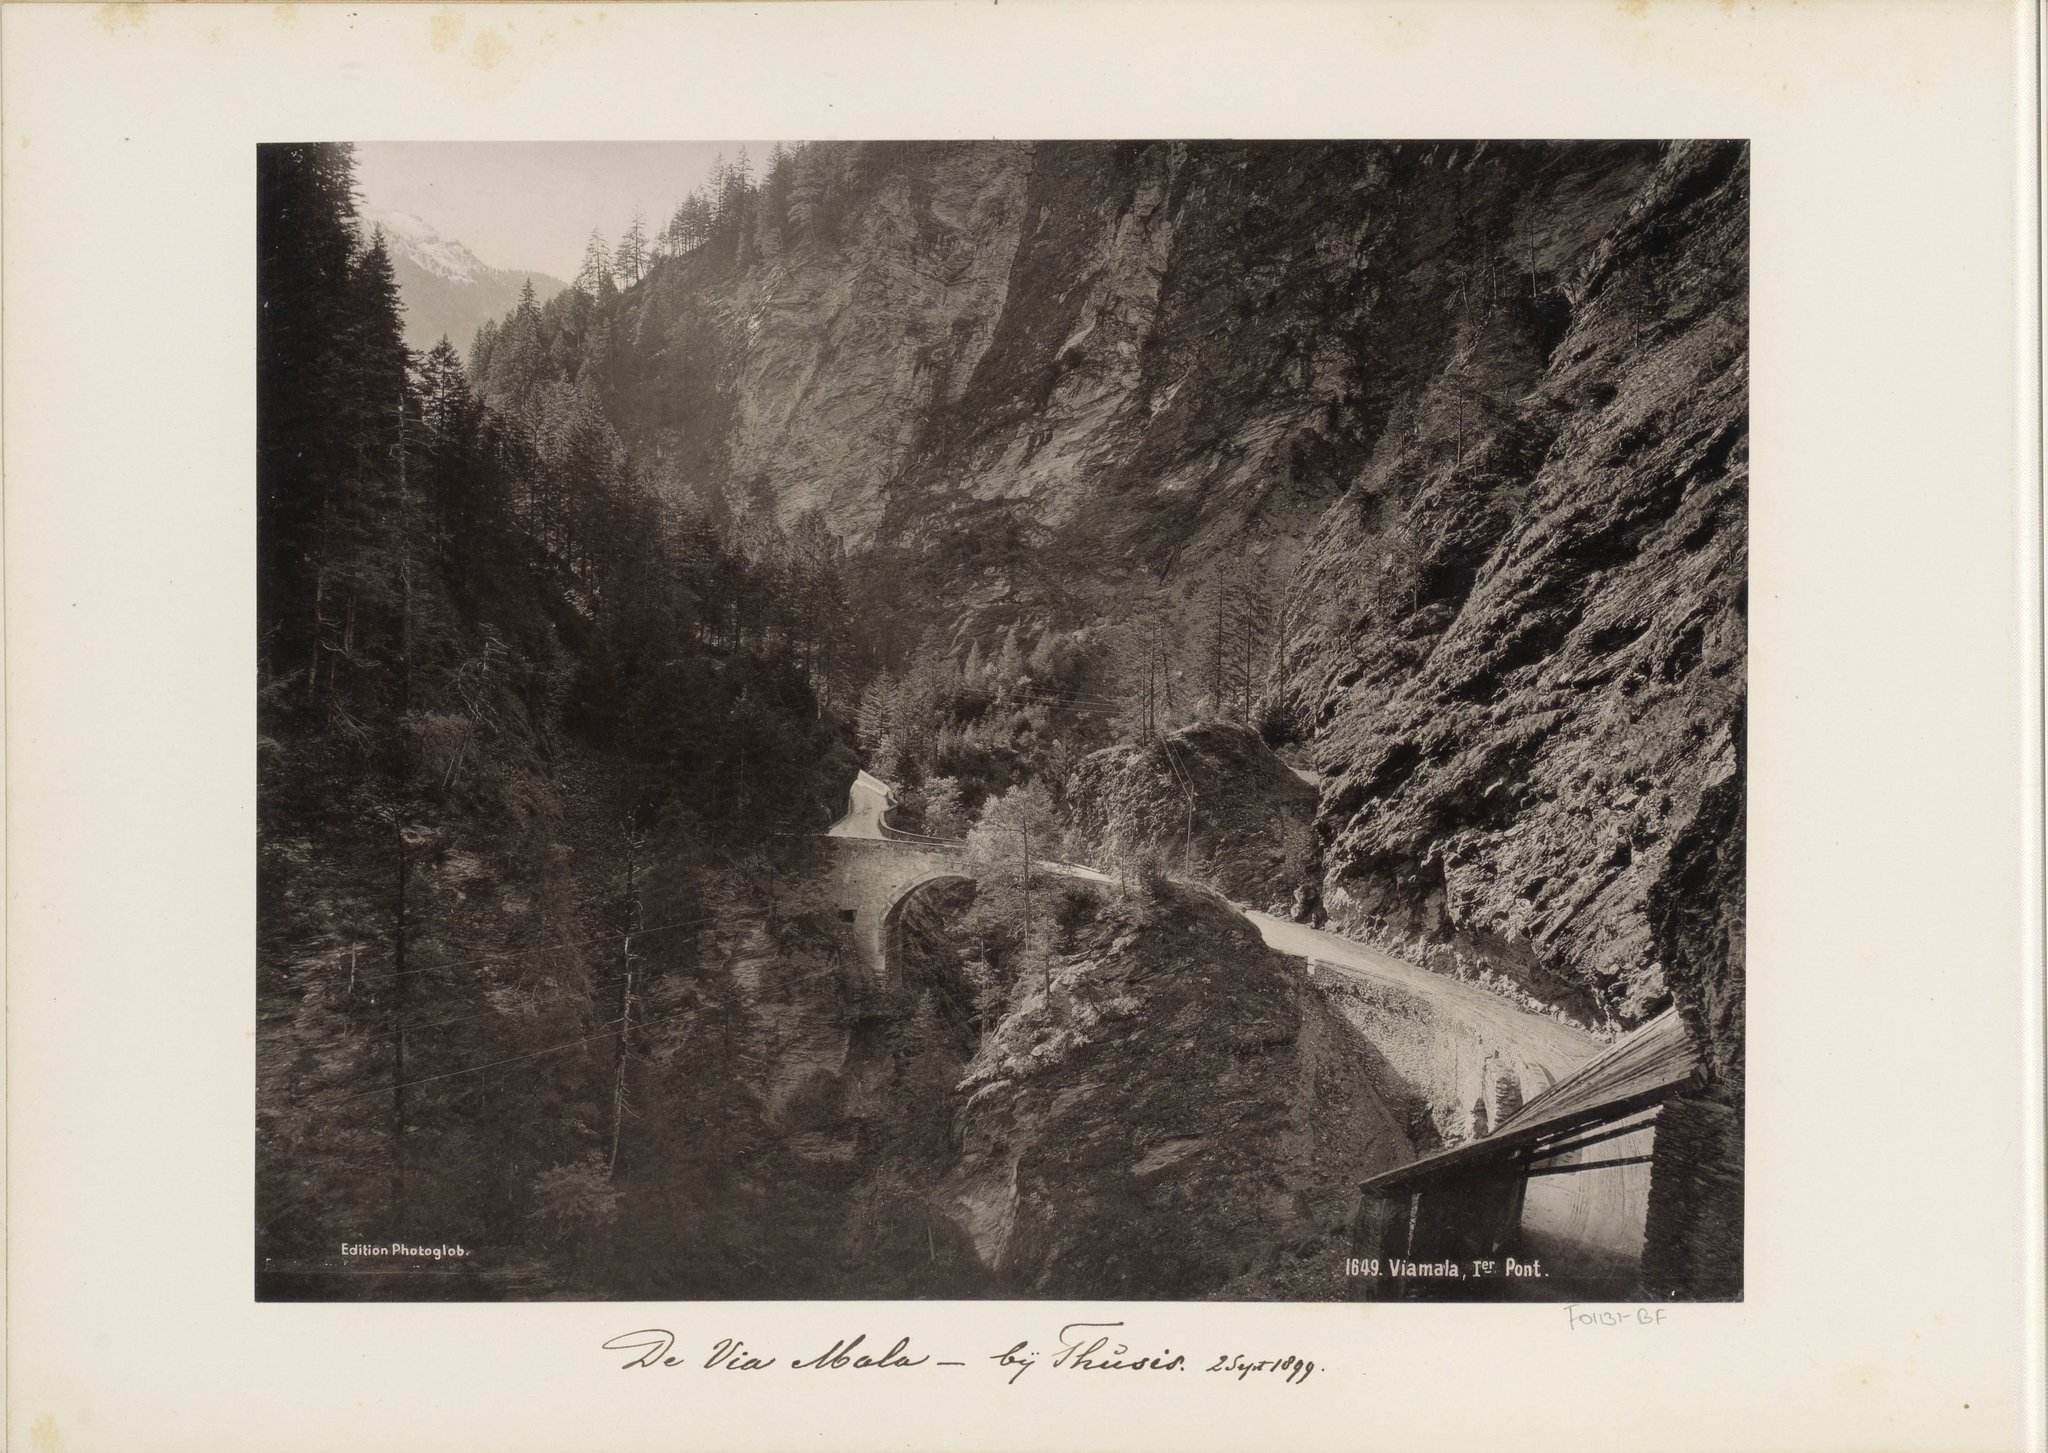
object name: album leaf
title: Via Mala, Ier Pont.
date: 1880-1899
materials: paper, photographic support, ink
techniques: photograph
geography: graubunden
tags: landscape with bridge, viaduct or aqueduct, road, path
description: Onderdeel van Reisalbum met bezienswaardigheden in Duitsland, Oostenrijk, Zwitserland, Luxemburg en België.